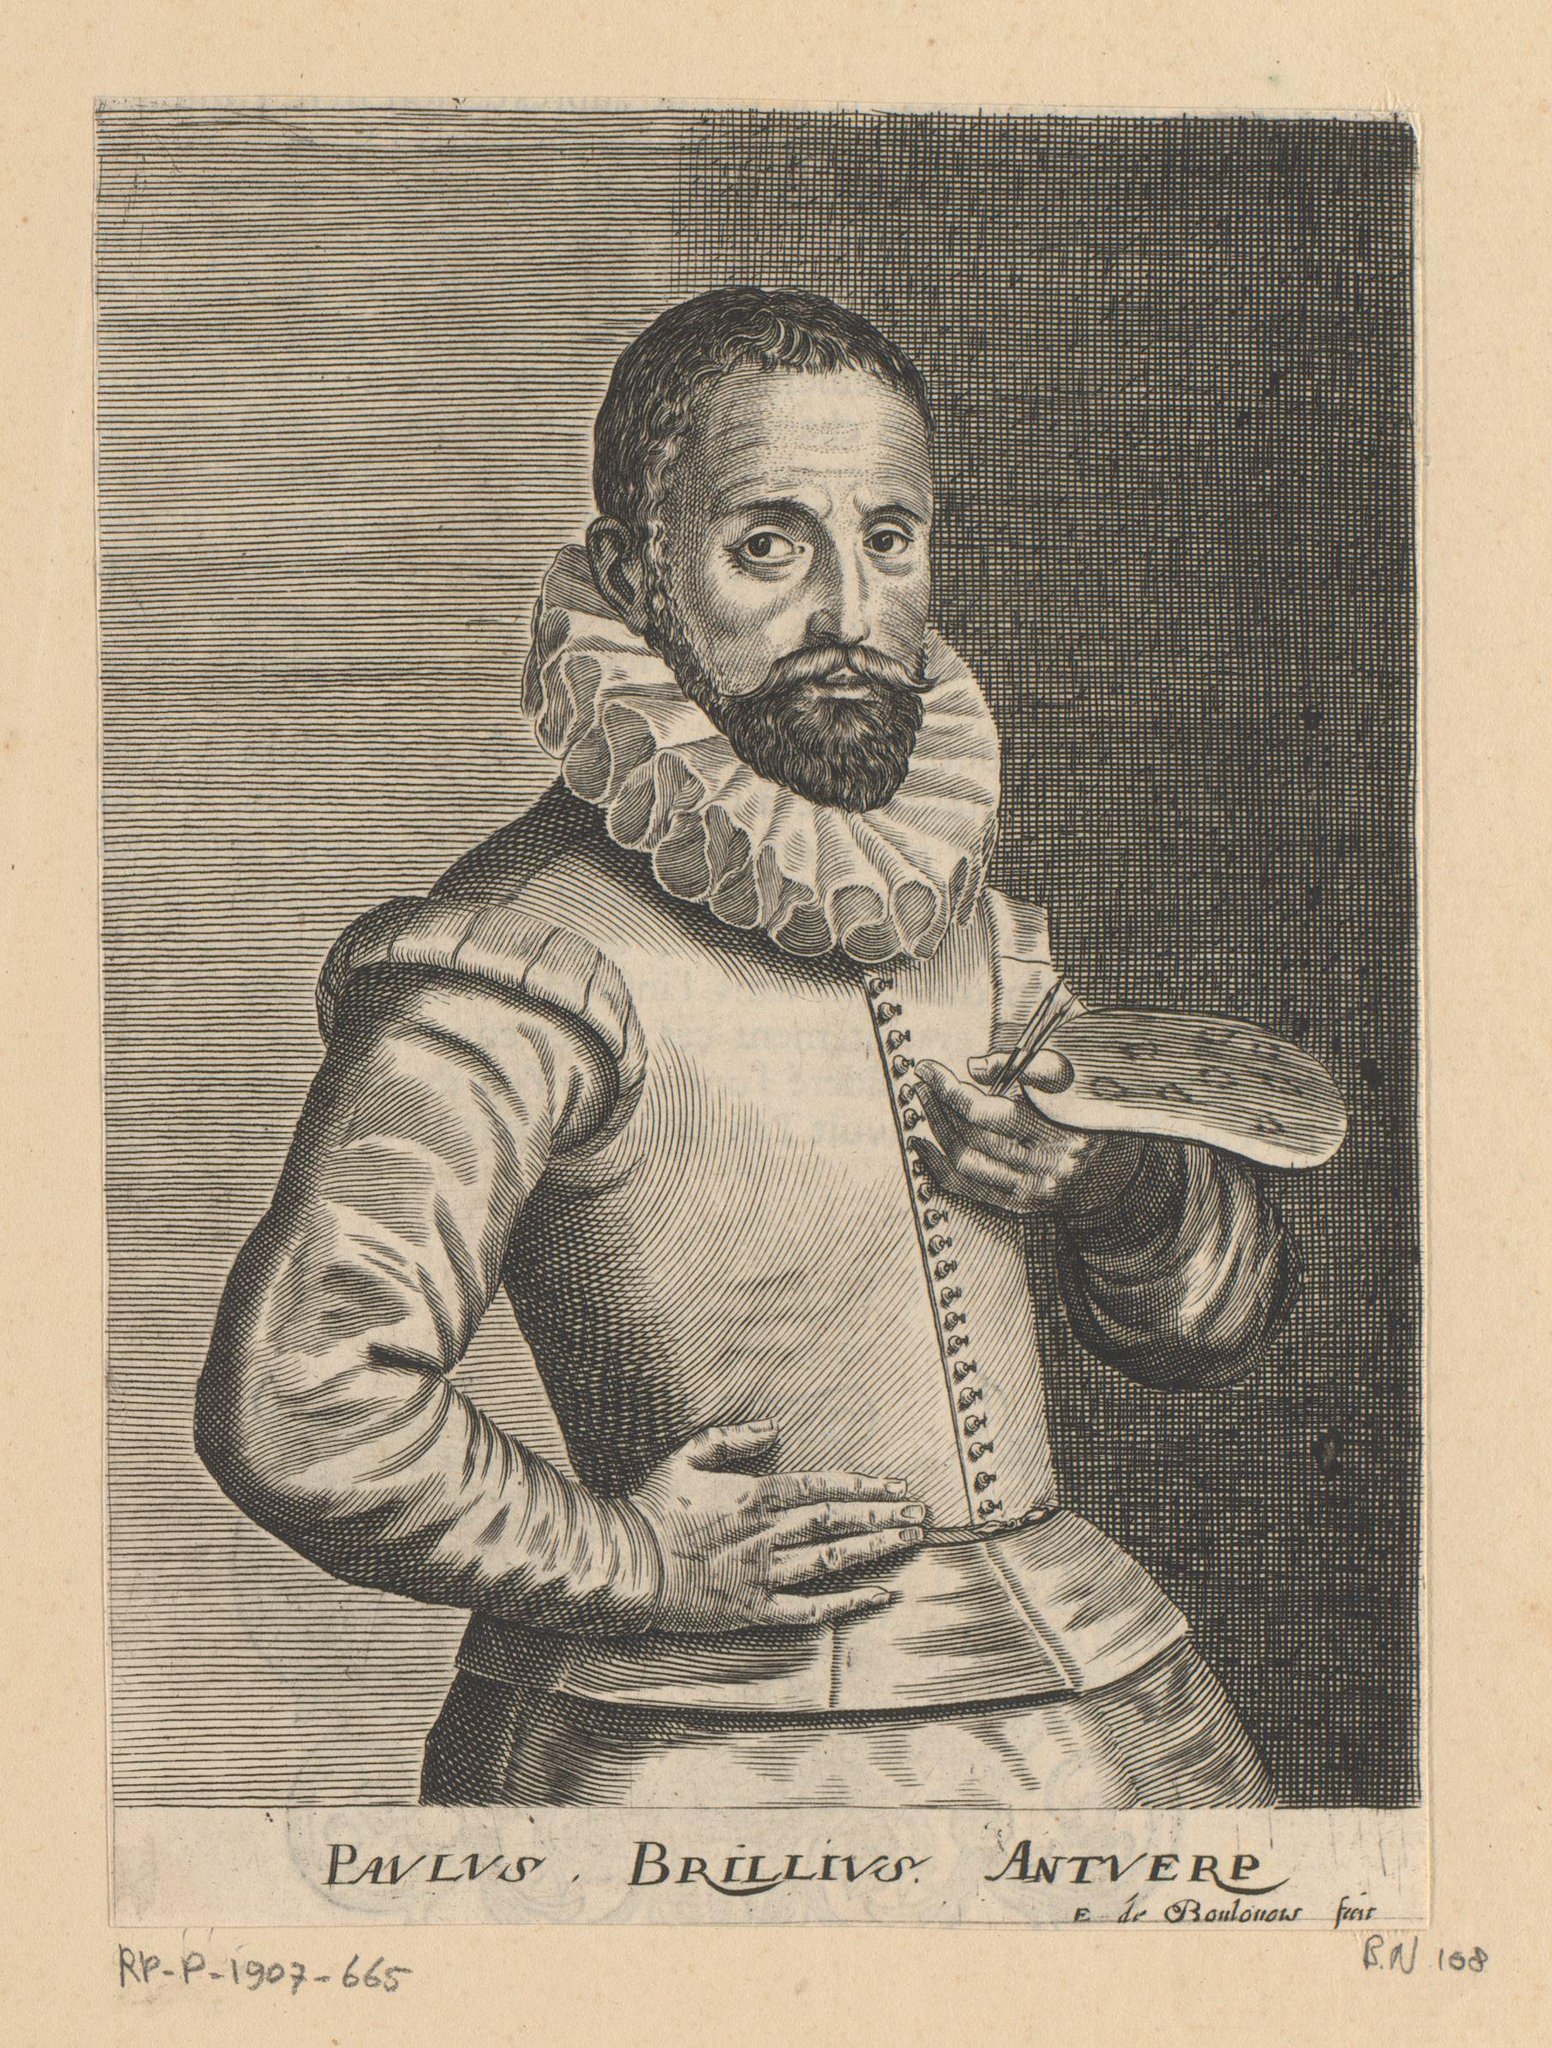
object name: book illustration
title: Portret van Paul Bril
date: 1682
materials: paper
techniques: engraving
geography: brussels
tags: antwerp, print maker, draughtsman, paul bril, historical persons, portrait, self-portrait of artist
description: Prent uit: Bullert, Isaac. Académie des Sciences et Arts contenant les vies et éloges his. des hommes illustres qui ont excellé en ces professions depuis environ quatre siècles. Brussel: Foppens, François, 1682. Het boek werd in 1682 eveneens in Amsterdam uitgegeven door de erfgenamen van Daniel Elzevier. Deze portretten dienen ter illustratie van de biografie van een kunstenaar of geleerde. De meeste portretten werden door Nicolas de Larmessin vervaardigd (162), 93 door De Boulonois en een derde door ongeïdentificeerde prentmakers. Dit betreft een illustratie op p. 449, deel II.